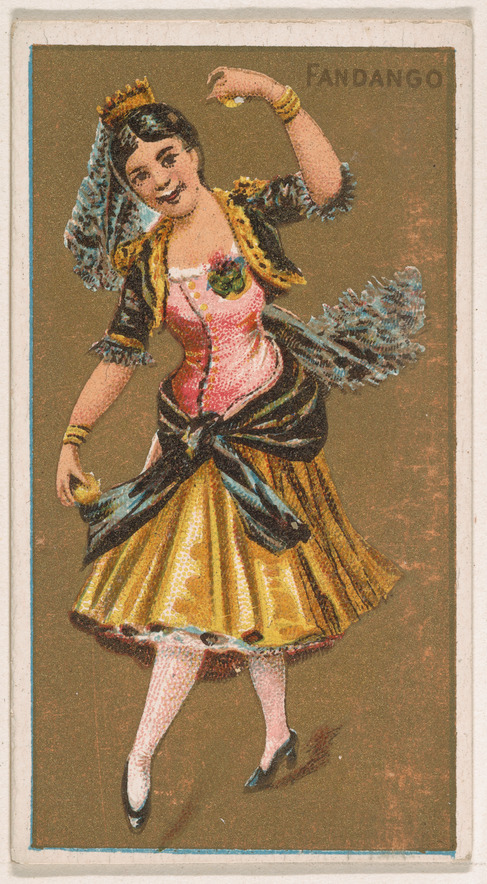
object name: print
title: Fandango, from National Dances (N225, Type 1) issued by Kinney Bros.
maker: kinney brothers tobacco company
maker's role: publisher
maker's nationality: american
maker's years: 1869-2011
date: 1889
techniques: color lithograph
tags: women,dancing,dancers